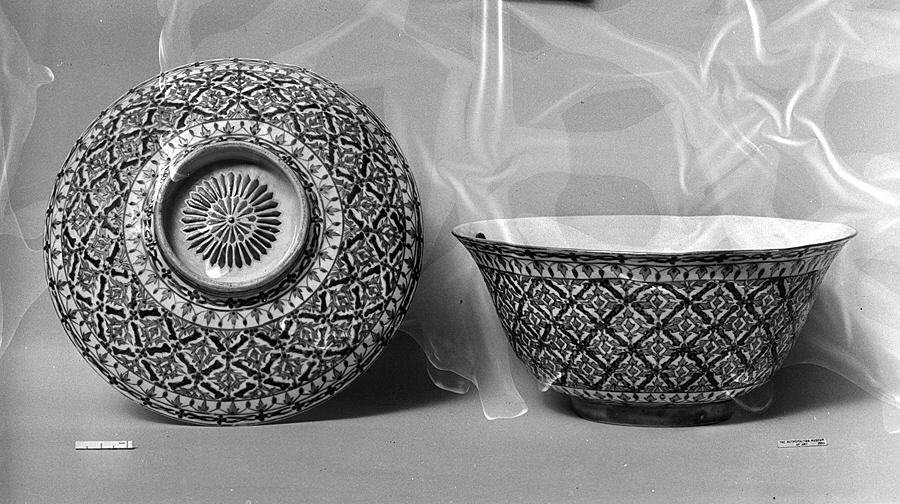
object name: covered bowl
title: Bowl with Saucer Cover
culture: chinese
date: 1767-1900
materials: enamel, porcelain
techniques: overglaze, painting, polychrome